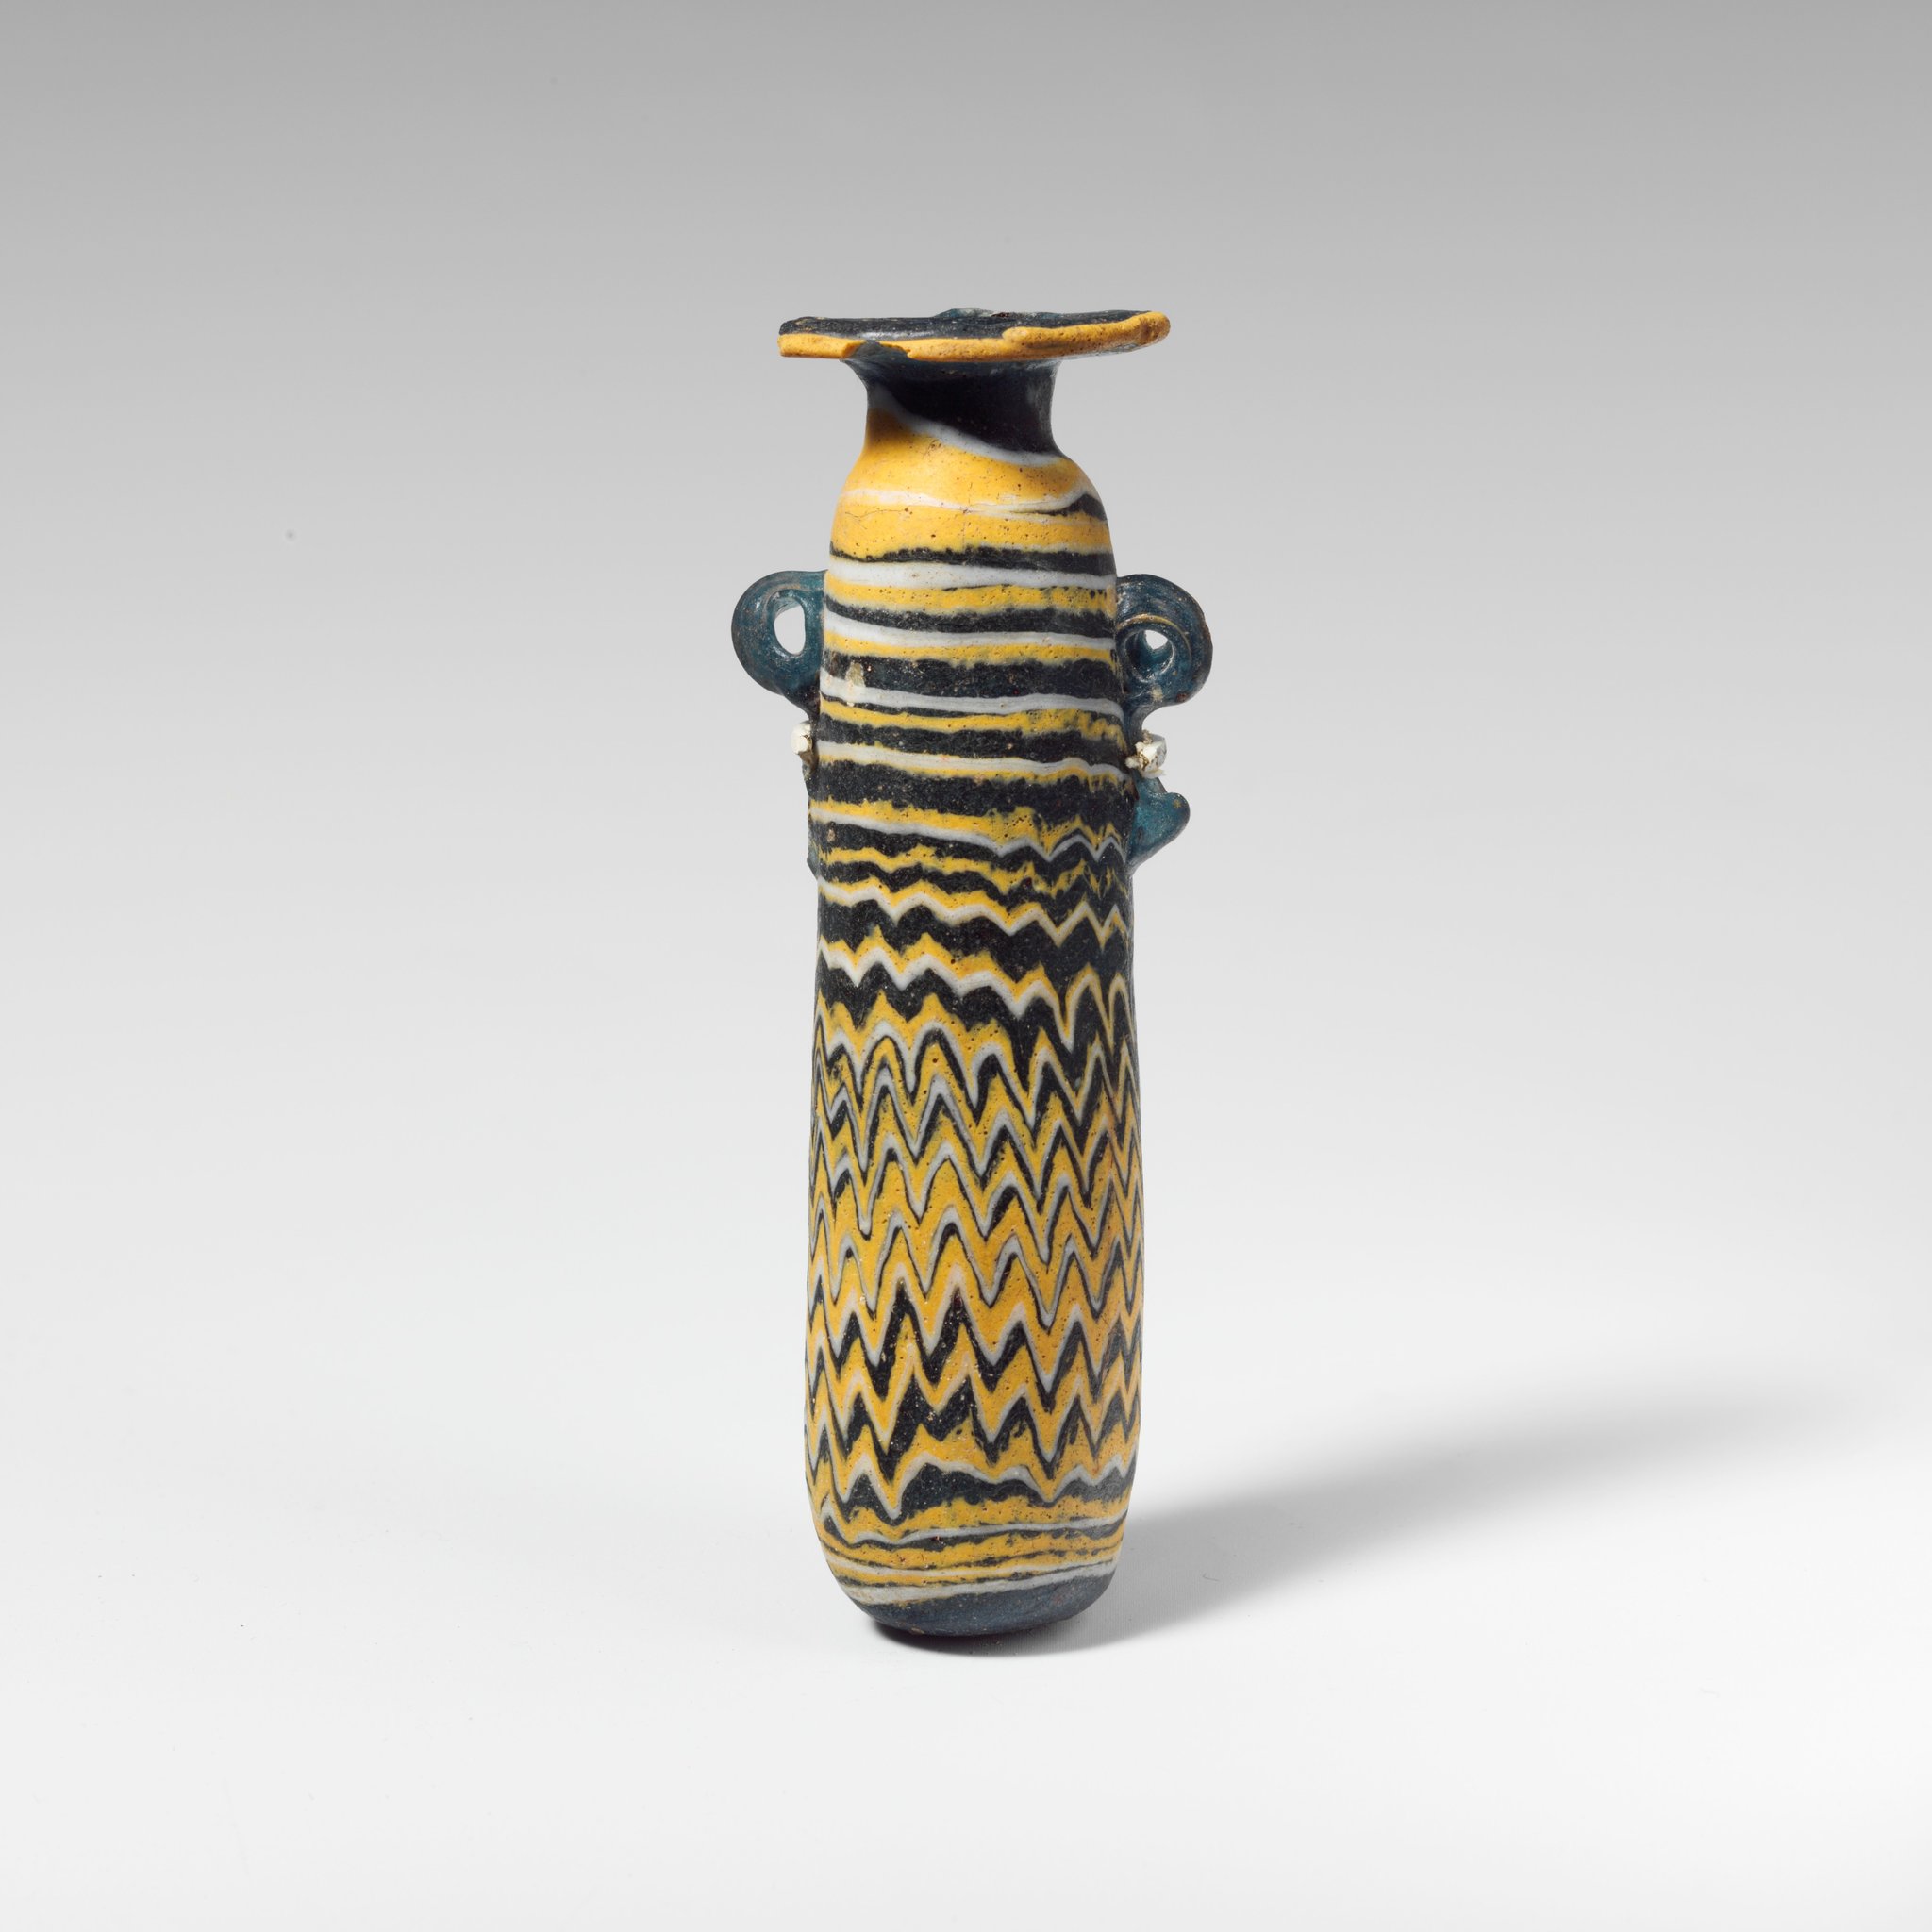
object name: alabastron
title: Glass alabastron (perfume bottle)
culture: greek, eastern mediterranean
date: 500-401 BCE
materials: glass